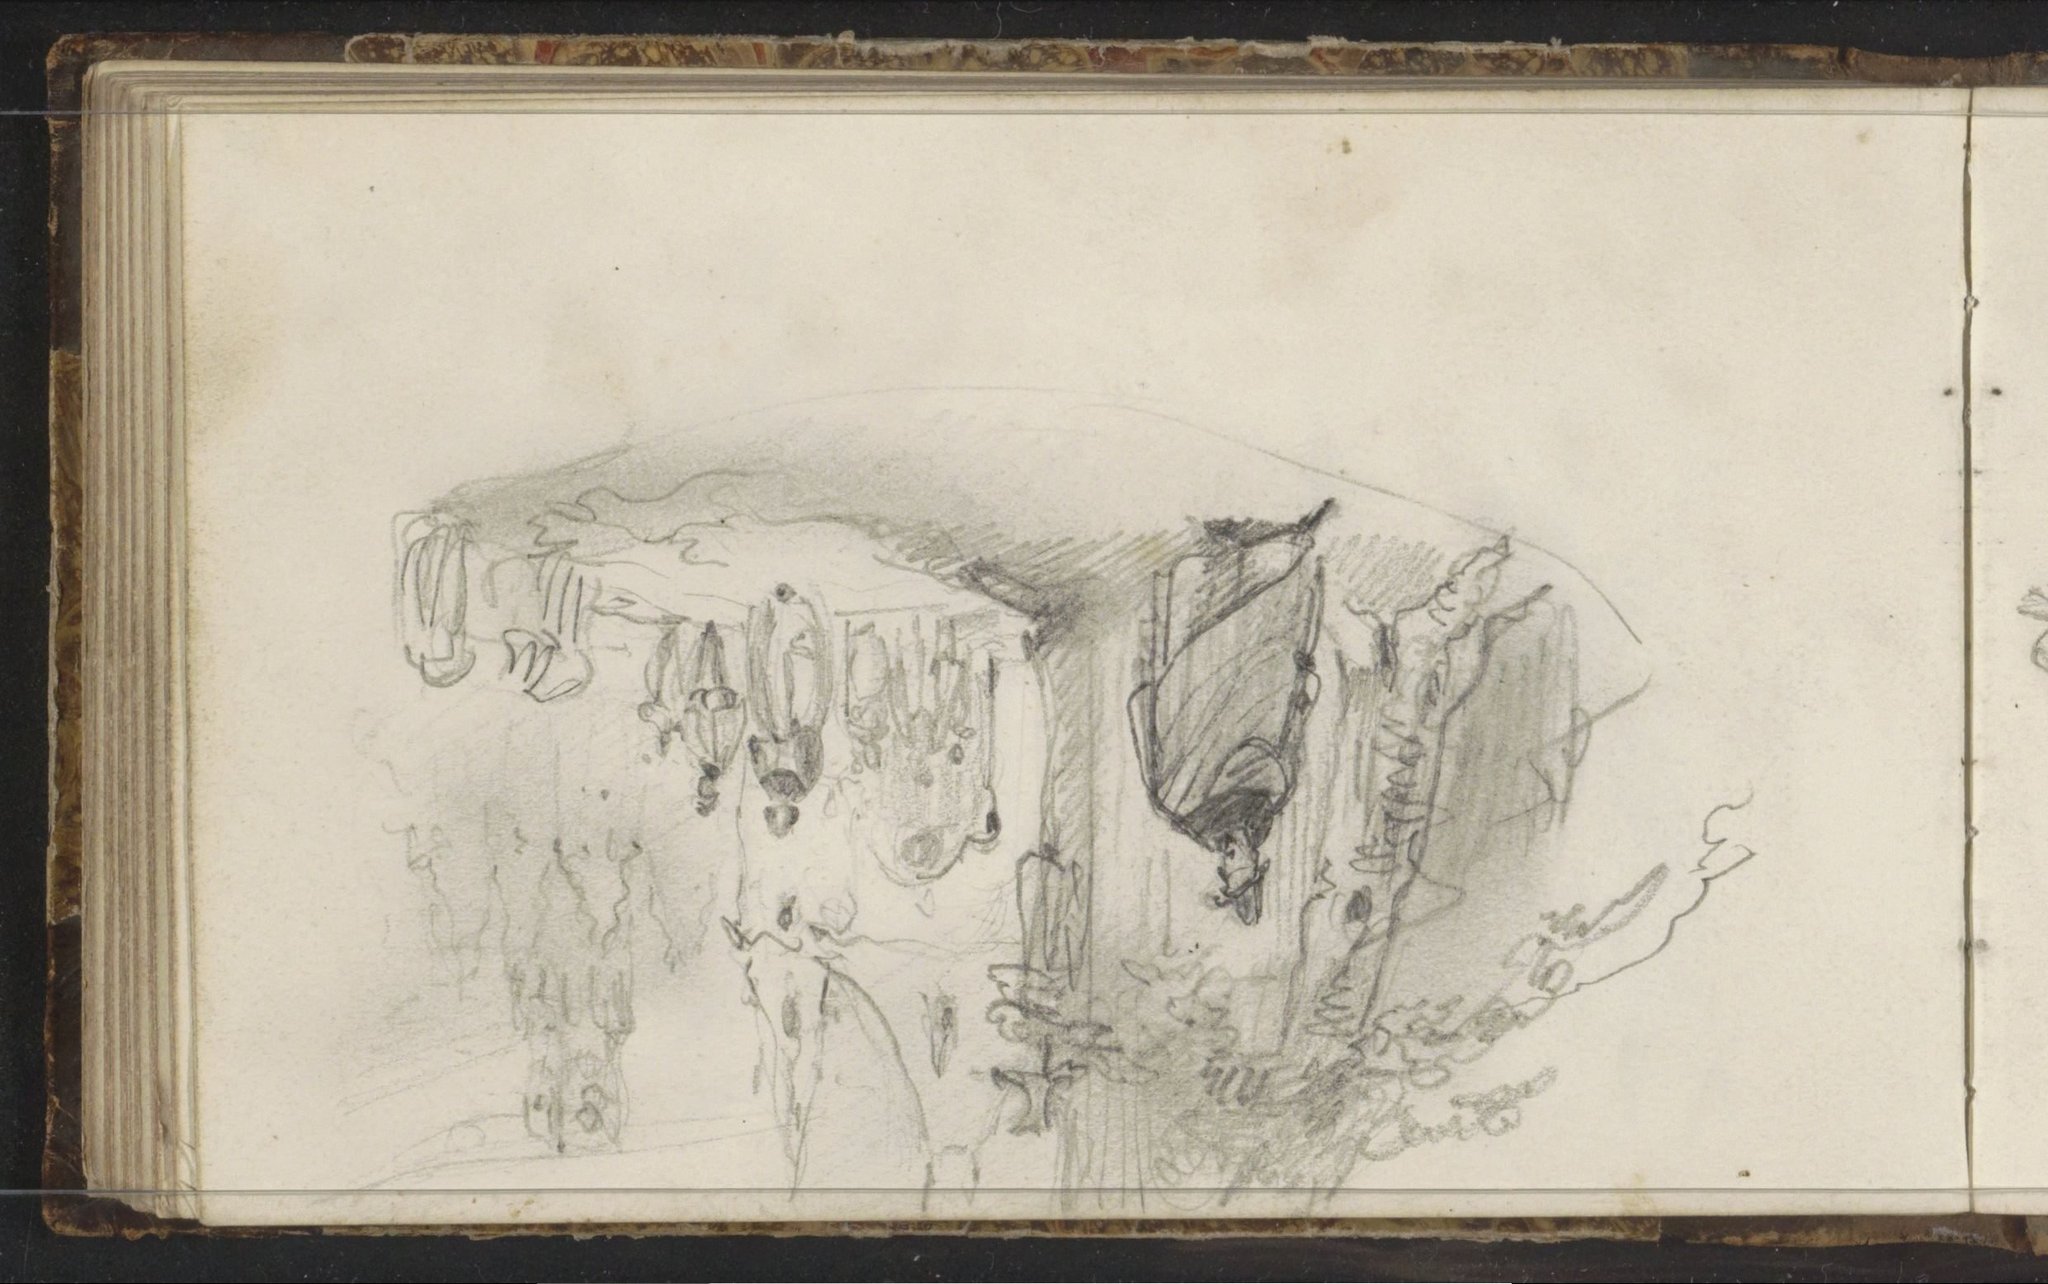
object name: sketchbook leaf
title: Groep figuren bij een gebouw met torens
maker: willem hendrik schmidt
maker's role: draughtsman, painter, print maker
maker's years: 1809-1849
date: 1819-1849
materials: paper, pencil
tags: street (+ city(-scape) with figures, staffage)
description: Op de voorgrond een man met een mantel en hoed bij een boom. Op de achtergrond de contouren van huizen en een toren. Blad 46 verso uit een schetsboek met 60 bladen.